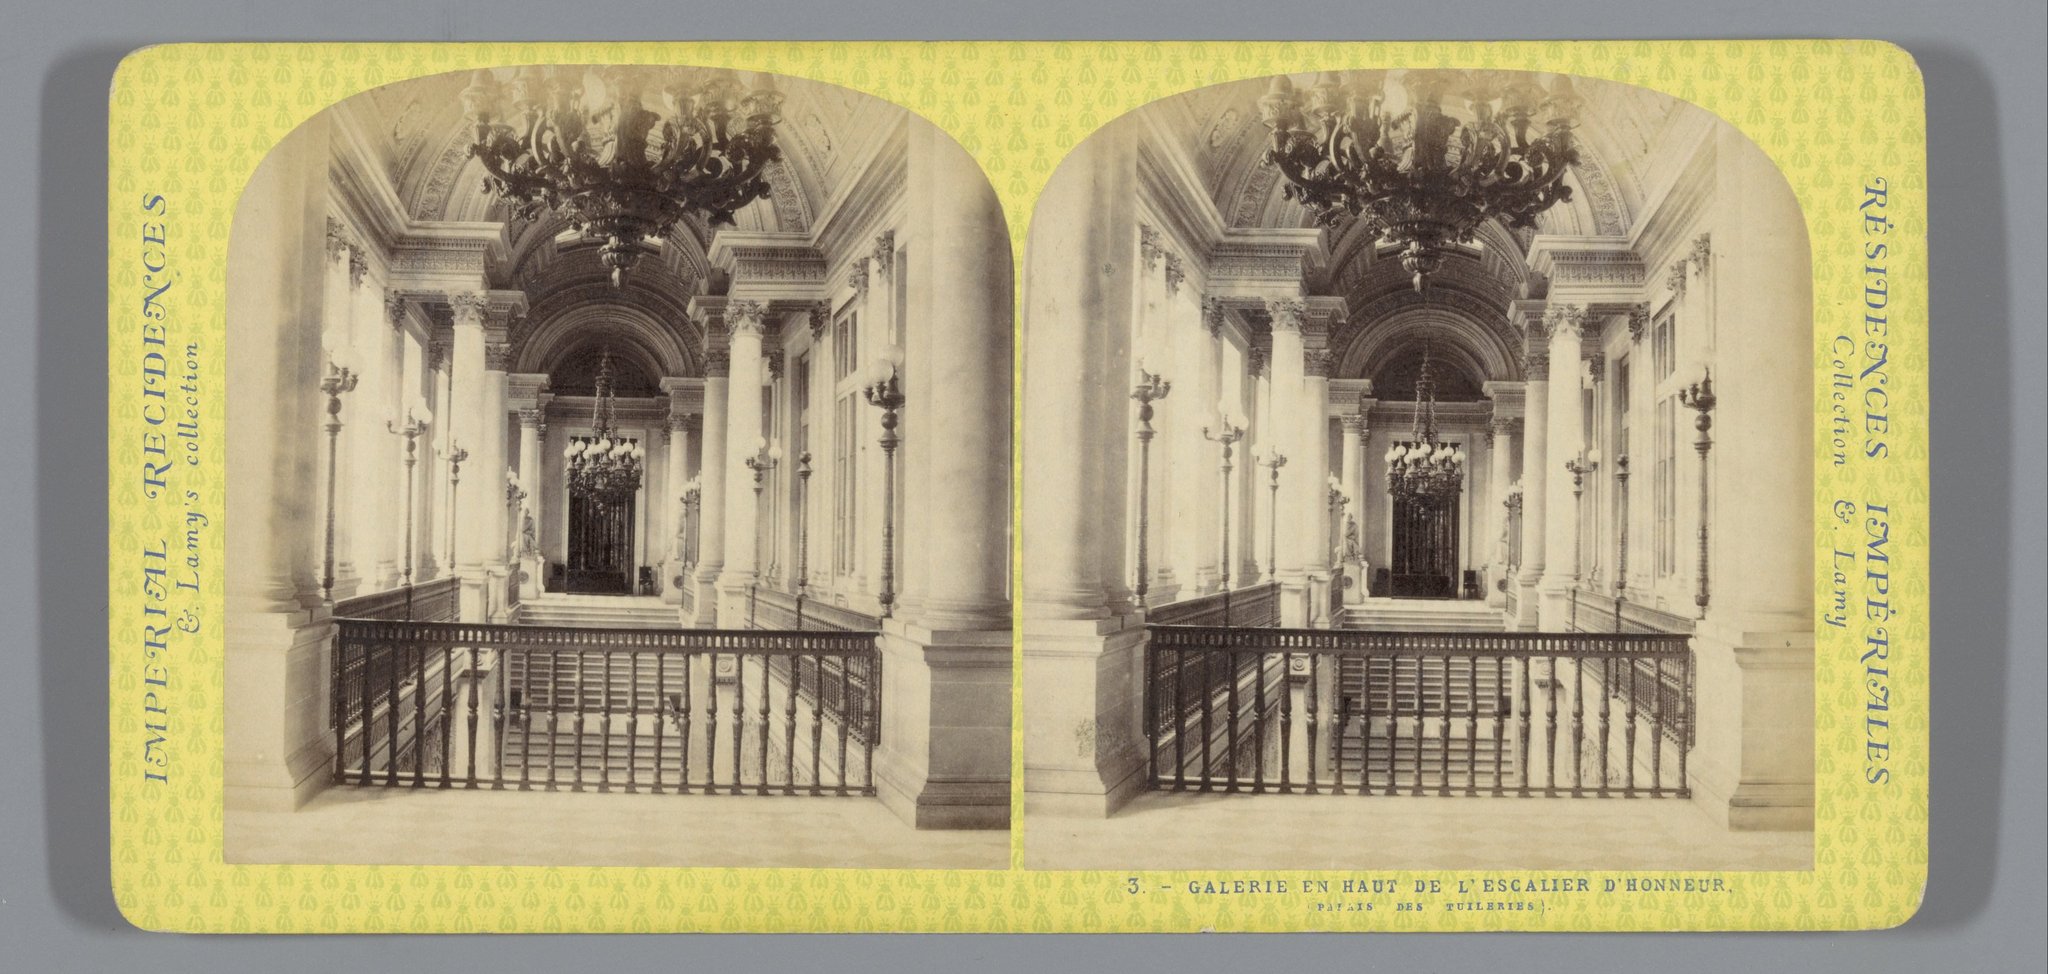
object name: stereograph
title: Trappenhuis van het Palais des Tuileries te Parijs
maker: ernest eléonor pierre lamy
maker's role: publisher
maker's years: 1828-1900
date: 1860-1871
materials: cardboard, photographic support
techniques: albumen print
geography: tuileries palace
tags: staircase, tuileries palace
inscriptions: number: ‘3.’, inscription: ‘E. Lamy's collection’